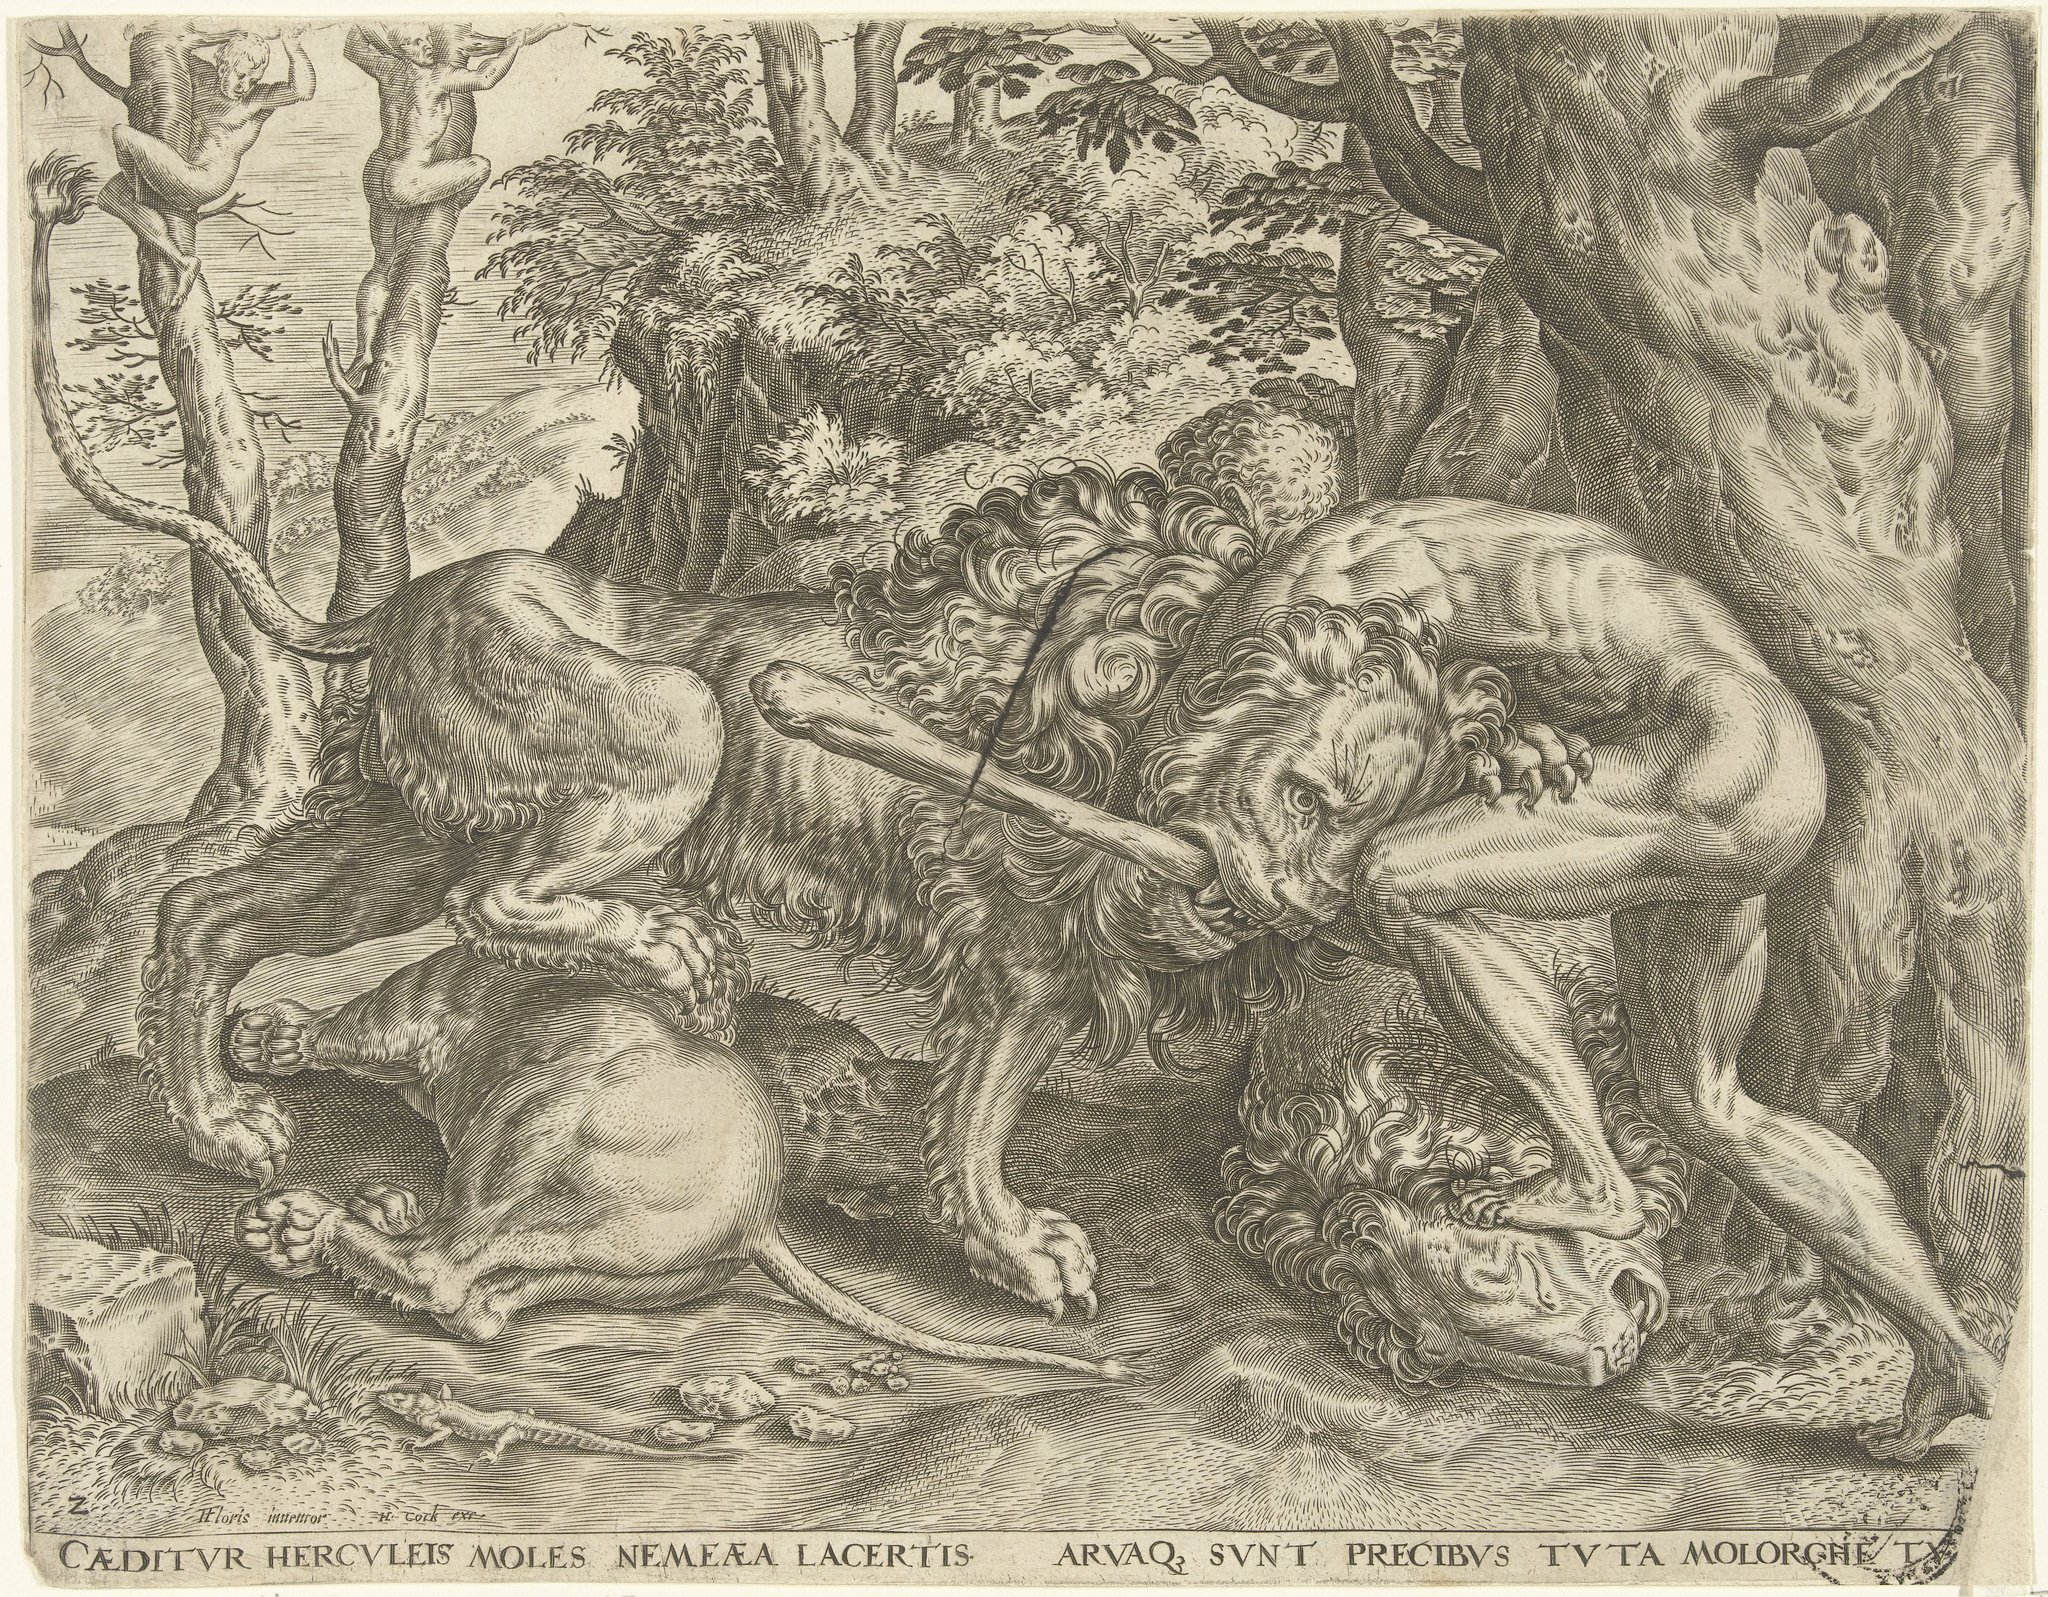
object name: print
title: Hercules wurgt de Nemeïsche leeuw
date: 1563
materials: paper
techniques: engraving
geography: antwerp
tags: the twelve labours of hercules: second series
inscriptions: collector's mark: Lugt 11, collector's mark: Lugt 10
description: Hercules doodt de leeuw die de inwoners van de stad Nemea terroriseerde. De enige manier om de leeuw te doden was hem te wurgen. Hercules staat met zijn voet op het hoofd van een andere, al dode leeuw en wurgt de Nemeeïsche leeuw. De leeuw heeft Hercules' knots in zijn bek.